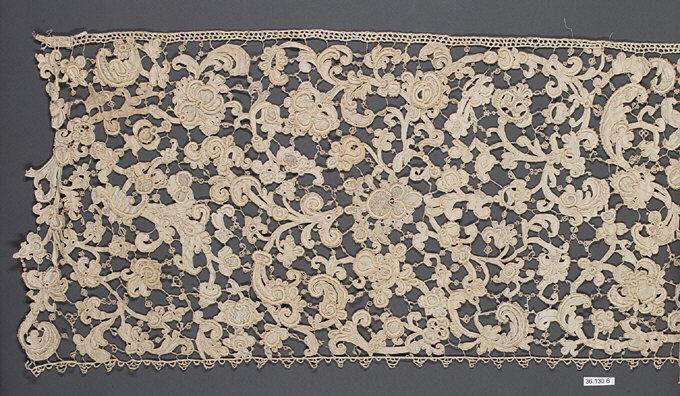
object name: flounce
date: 1660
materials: lace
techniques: gros point, lace